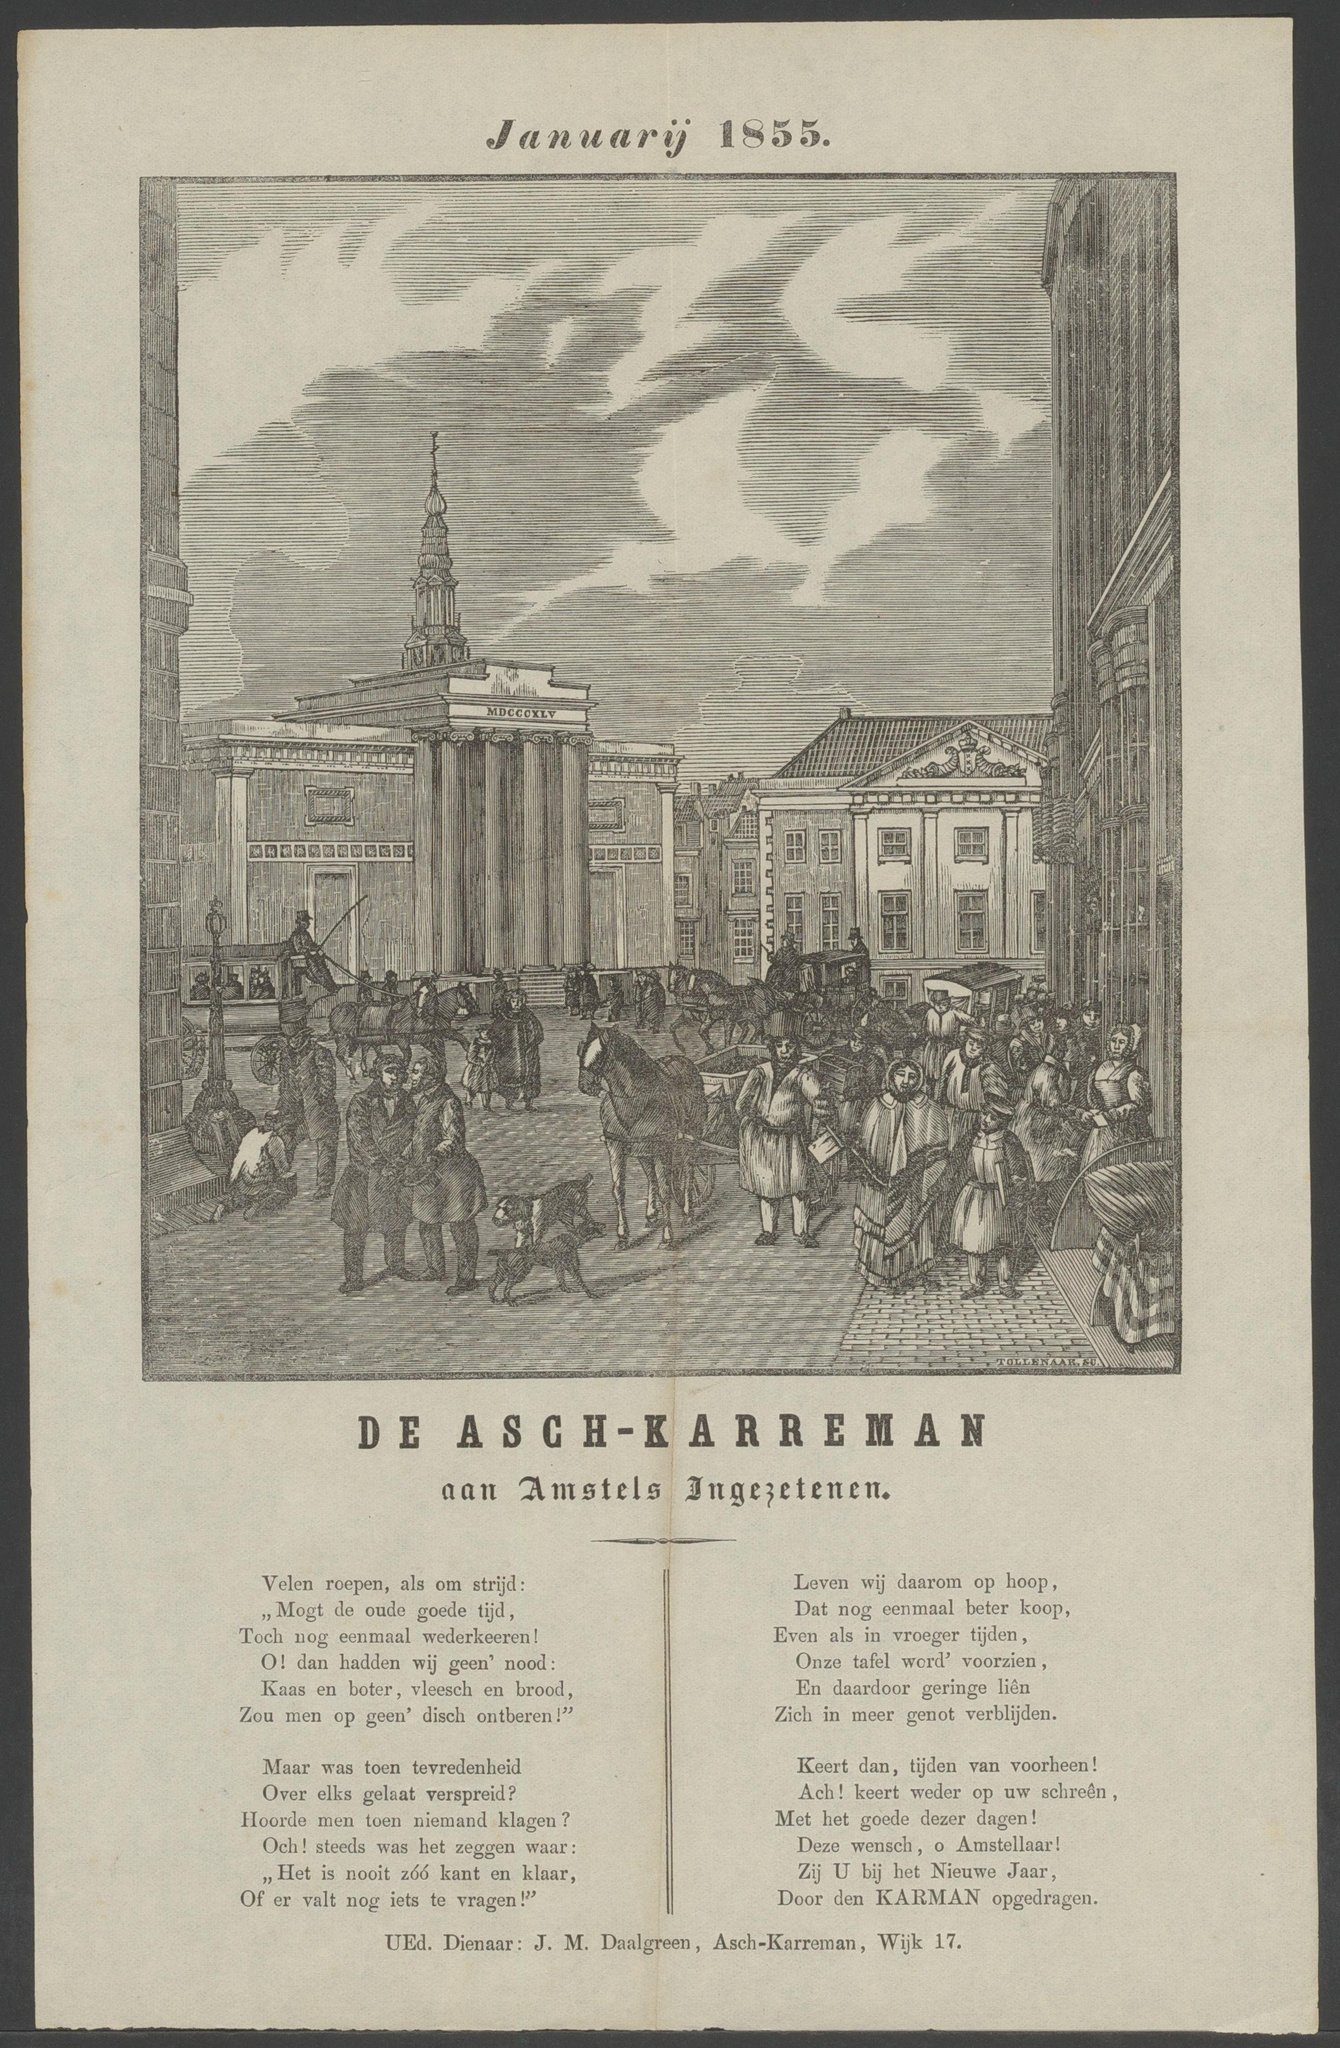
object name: print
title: De Asch-karreman aan Amstels Ingezetenen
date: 1854-1855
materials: paper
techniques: letterpress printing, engraving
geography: amsterdam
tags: street, garbage collection, amsterdam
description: Nieuwjaarswens van askarrenmannen (karrenman of vuilnisman) van Amsterdam voor het jaar 1855. Gezicht op de Dam met de Beurs van Zocher en het Commandantshuis te Amsterdam. Tussen het publiek de vuilnismannen met hun kar. Met gedicht in twee kolommen. Van de vuilniskarman in de wijk no. 17: J.M. Daalgreen. Onderwerpsrubrieken binnen de Atlas Zeden en Gewoonten: Zeden en gewoonten in engeren zin, Volksleven, Volksbladen, Nieuwjaars- en Kerstwenschen, Amsterdam.